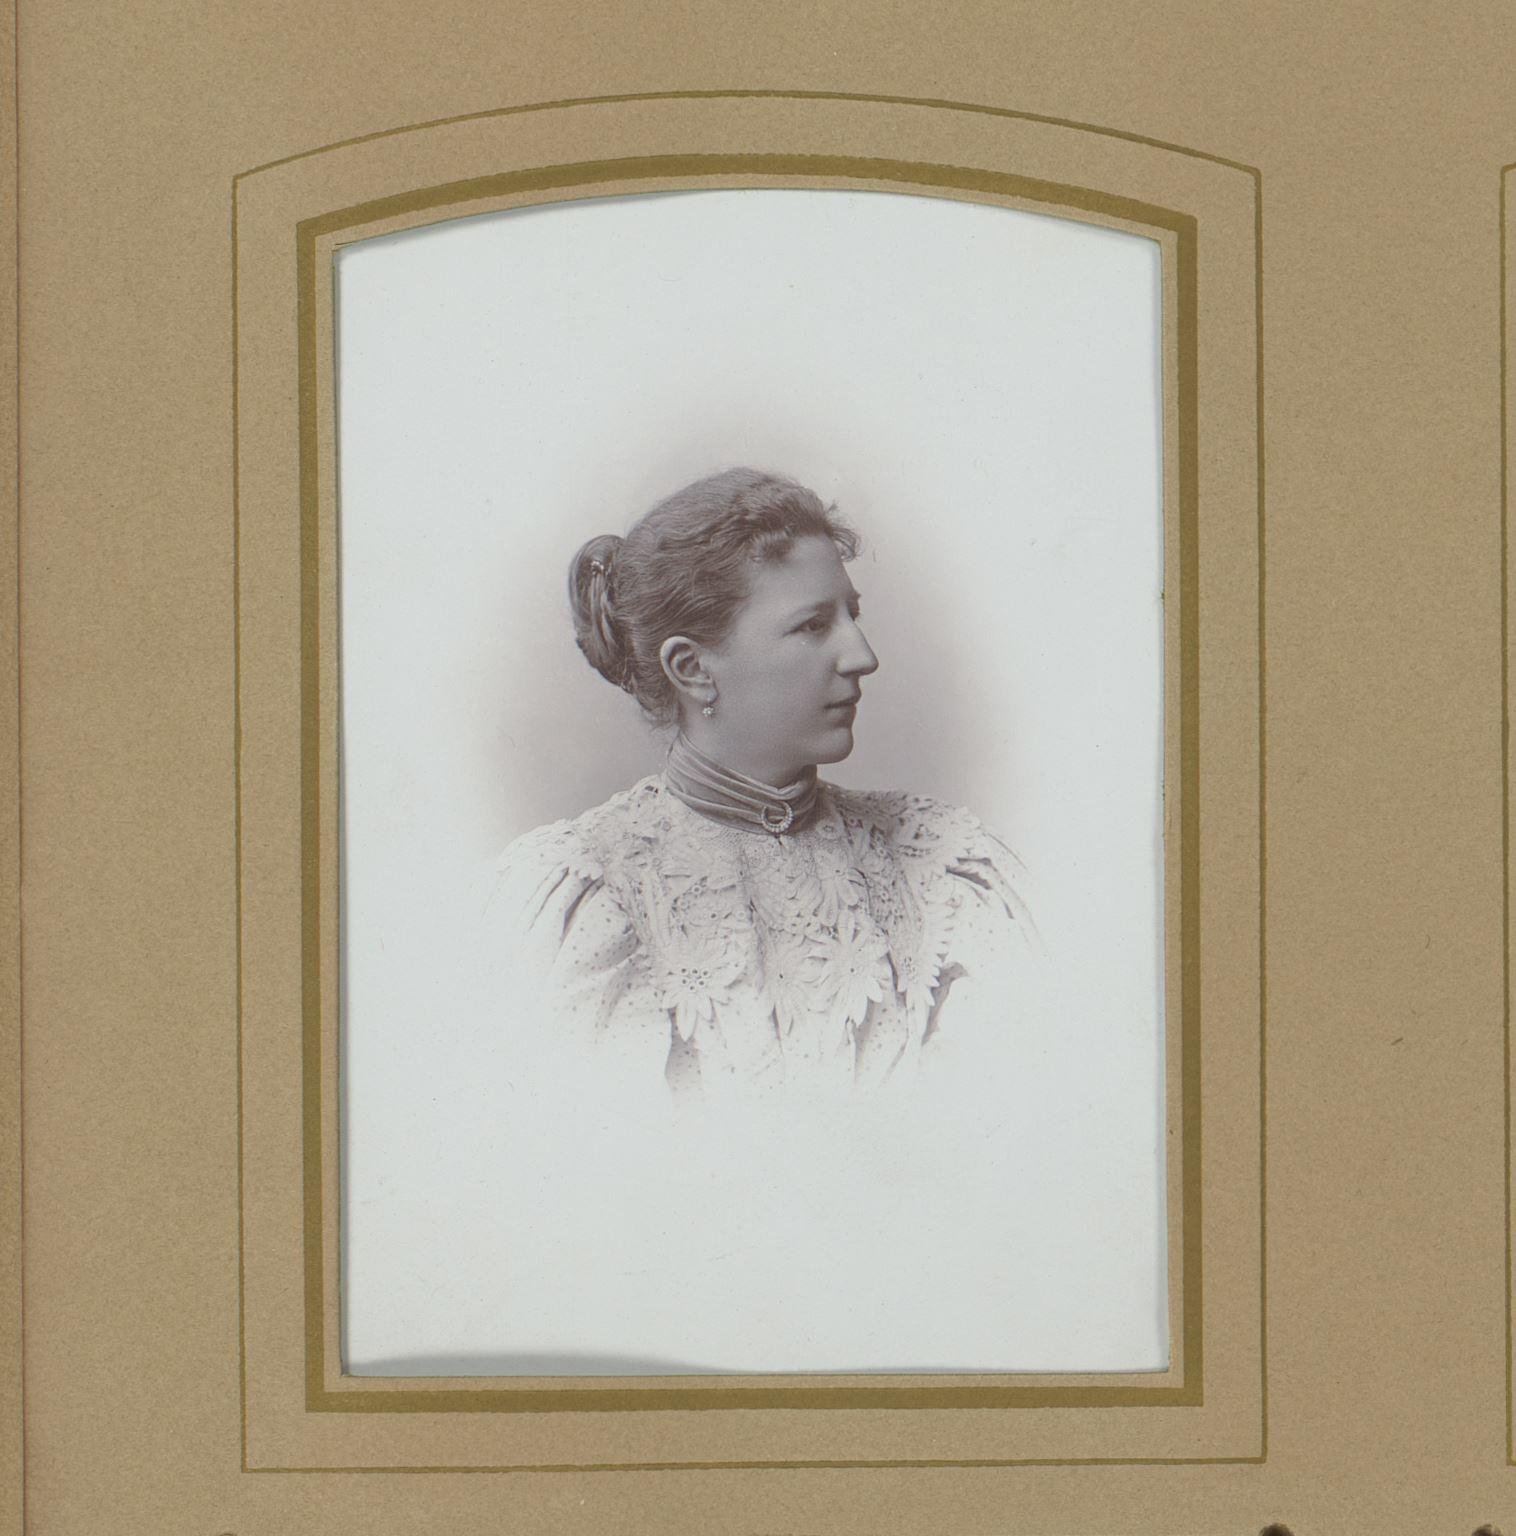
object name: cabinet photograph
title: Portret van een vrouw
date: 1894-1907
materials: cardboard, photographic support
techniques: matte daylight collodion silver print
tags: historical persons - bb - woman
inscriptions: inscription: ‘Koene & Büttinghausen/ Amsterdam/ Heerengracht 150./ Batavia.’